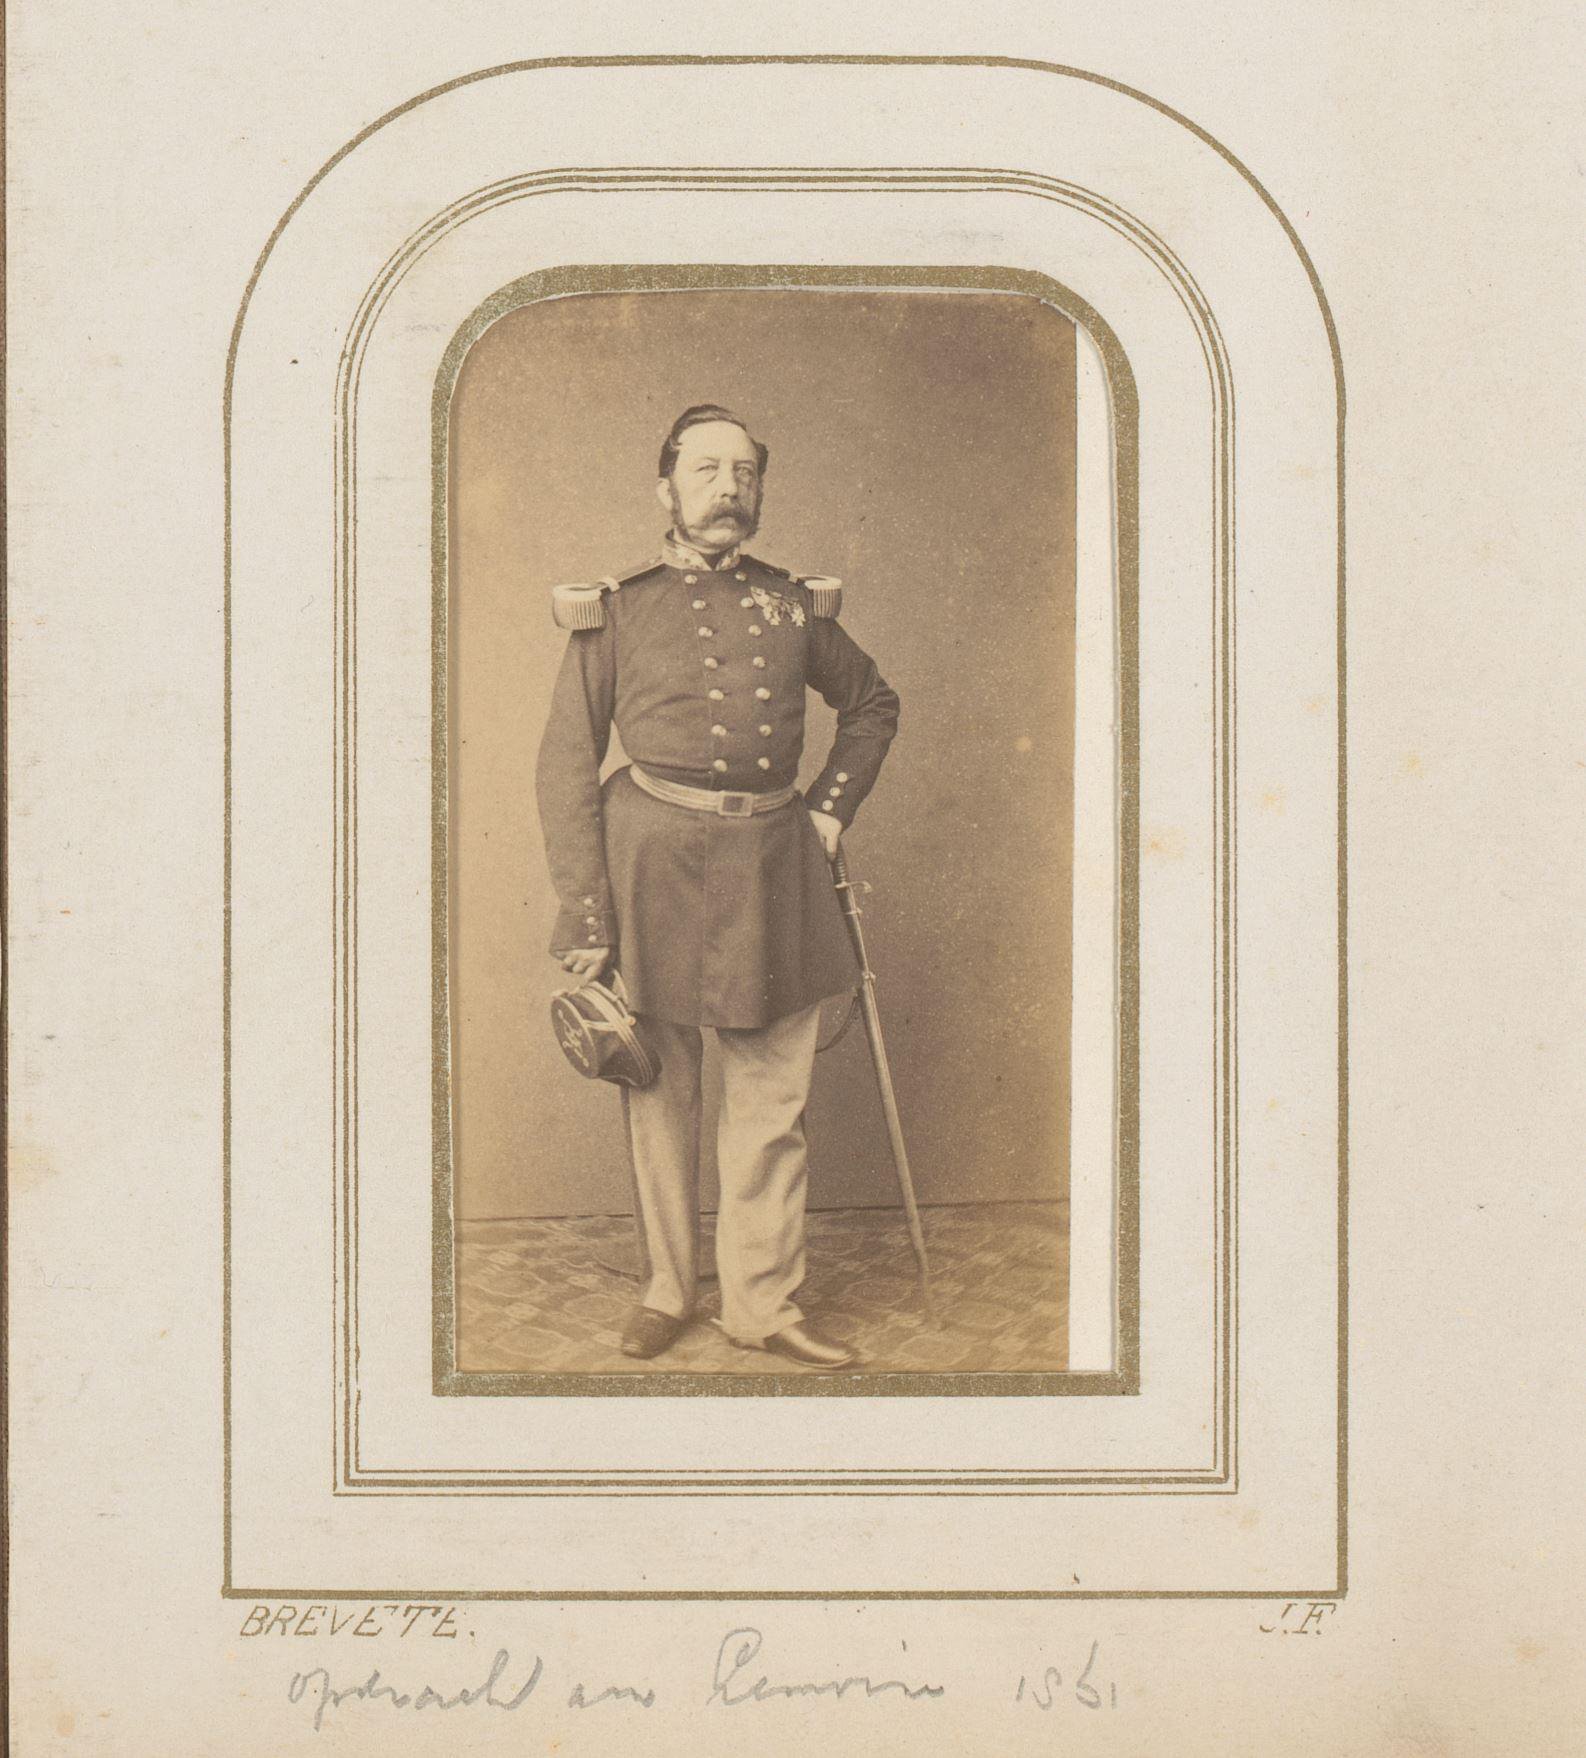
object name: photograph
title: Portret van een man in uniform met hoed en zwaard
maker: Anonymous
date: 1861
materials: cardboard, photographic support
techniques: albumen print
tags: historical persons, hacking and thrusting weapons: sword, (military) uniforms